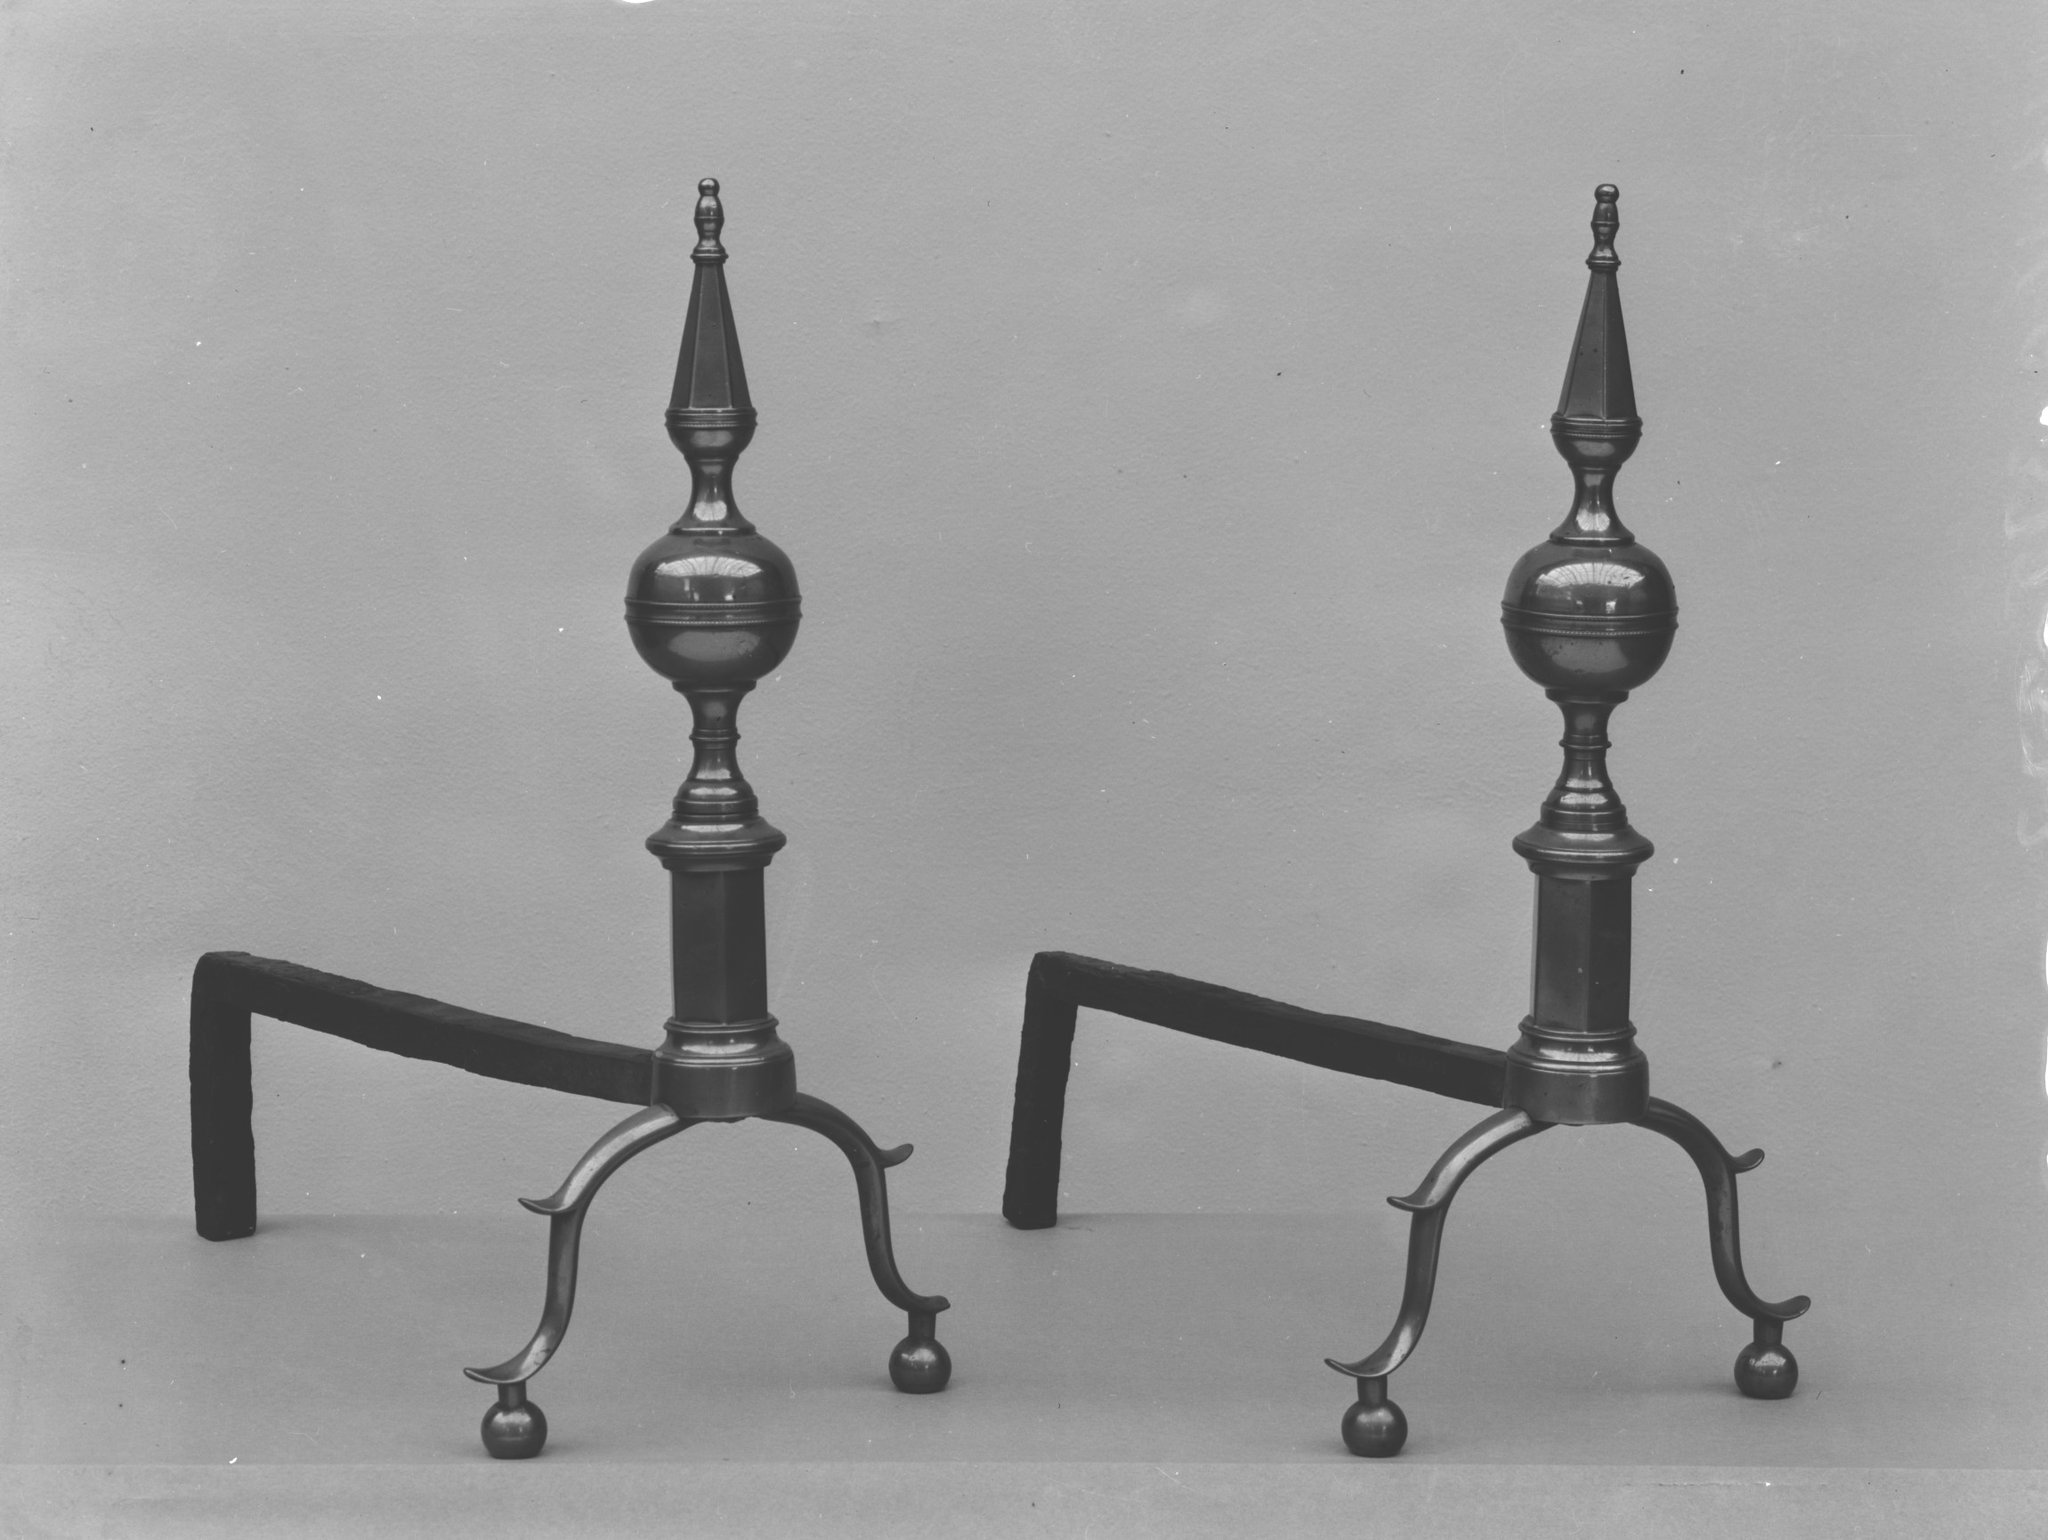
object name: andiron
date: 1770-1830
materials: brass